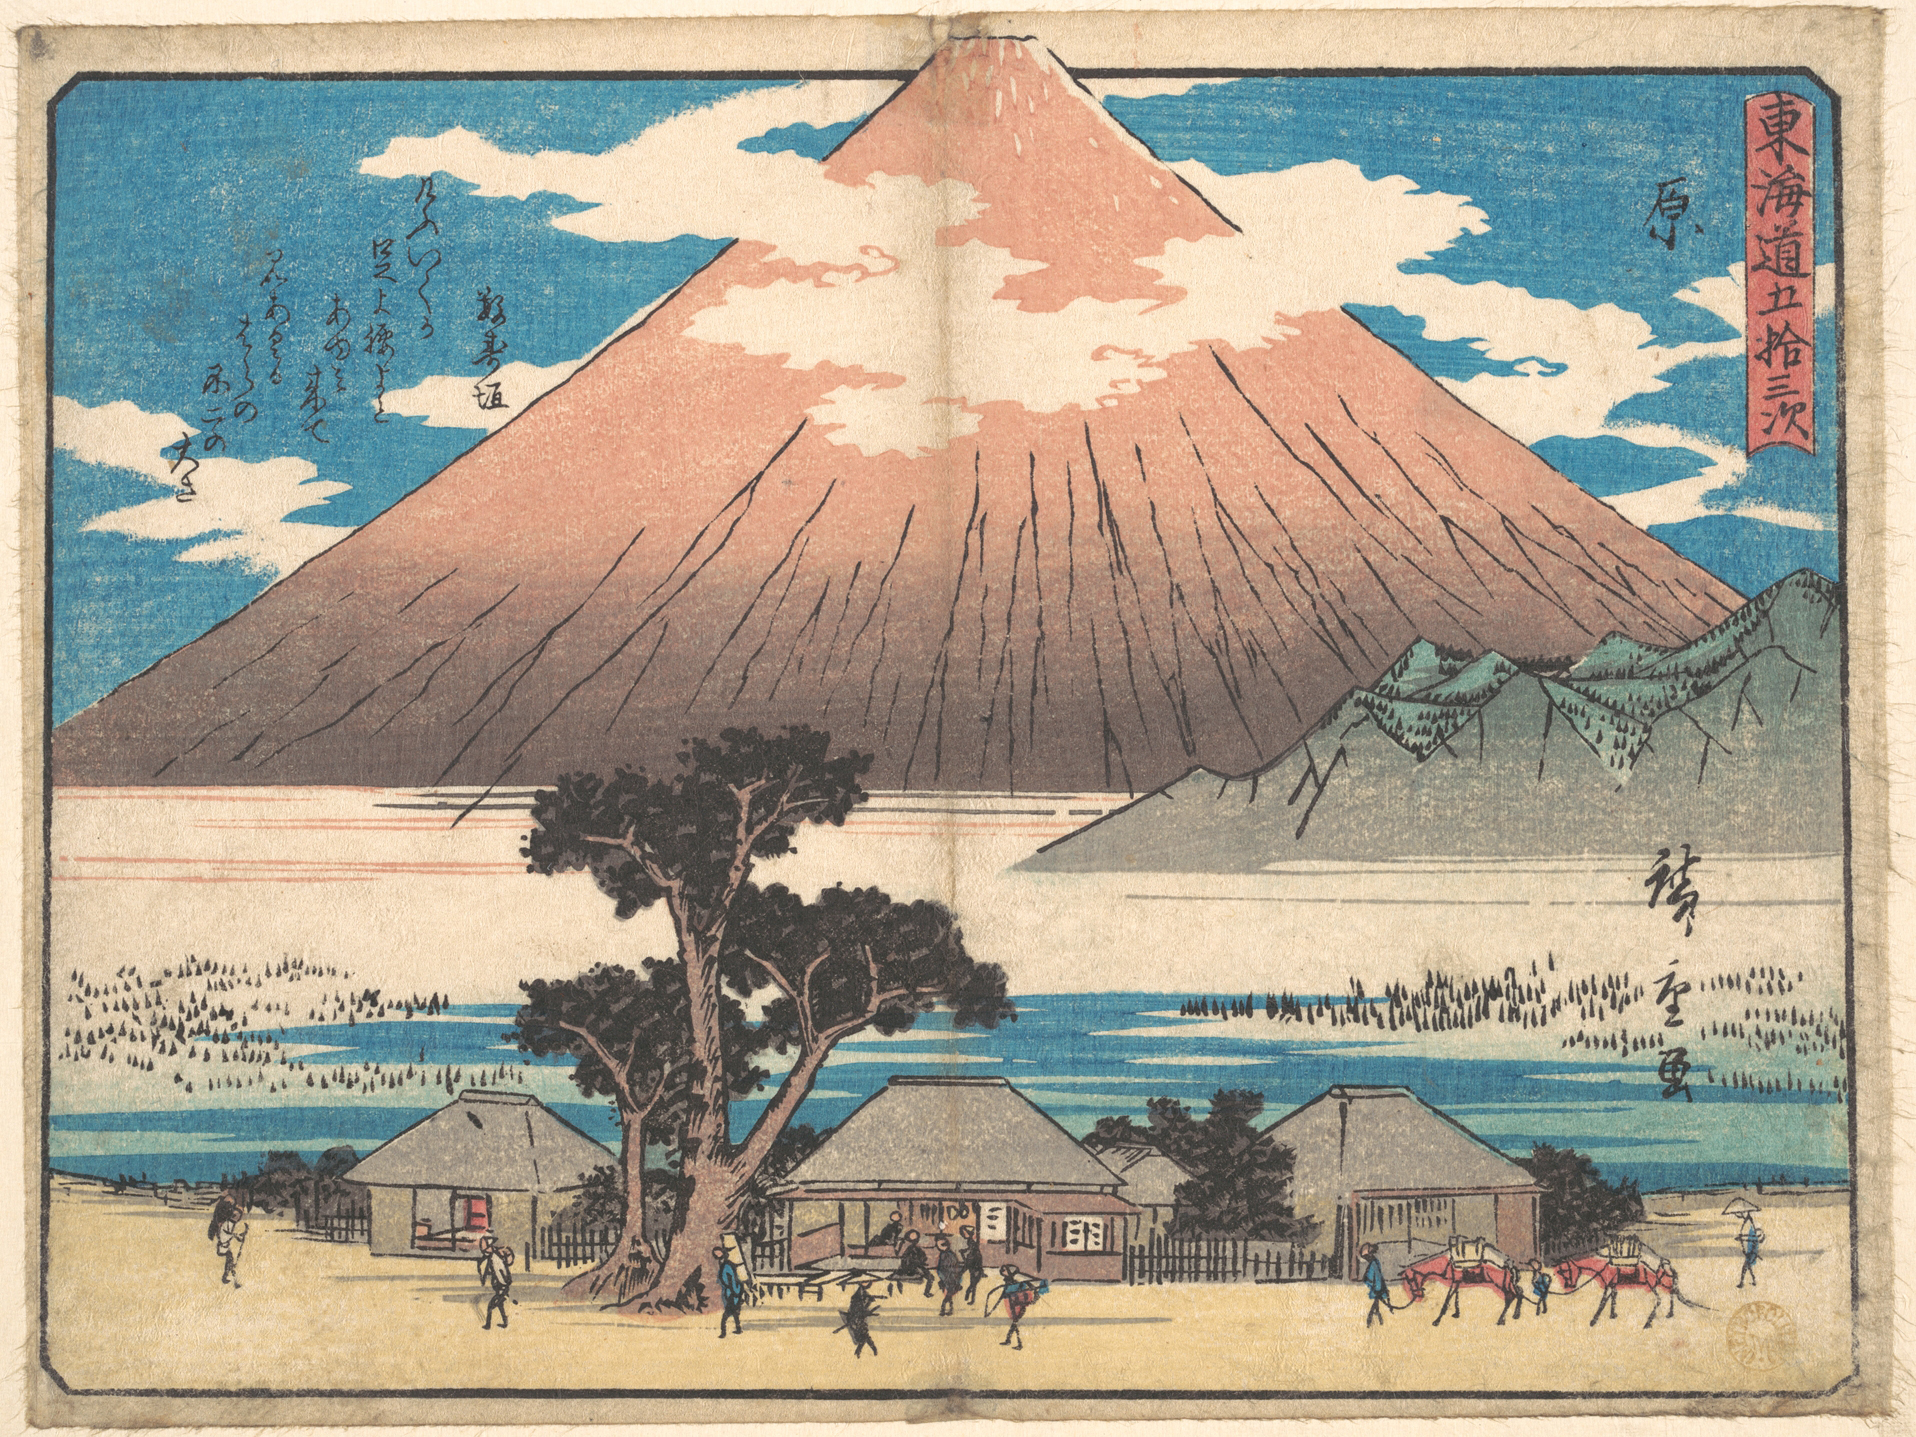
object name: print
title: Hara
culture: japanese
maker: utagawa hiroshige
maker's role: artist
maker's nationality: japanese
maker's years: 1797-1858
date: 1838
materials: ink, paper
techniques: woodblock print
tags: human figures,mountains,landscapes,trees